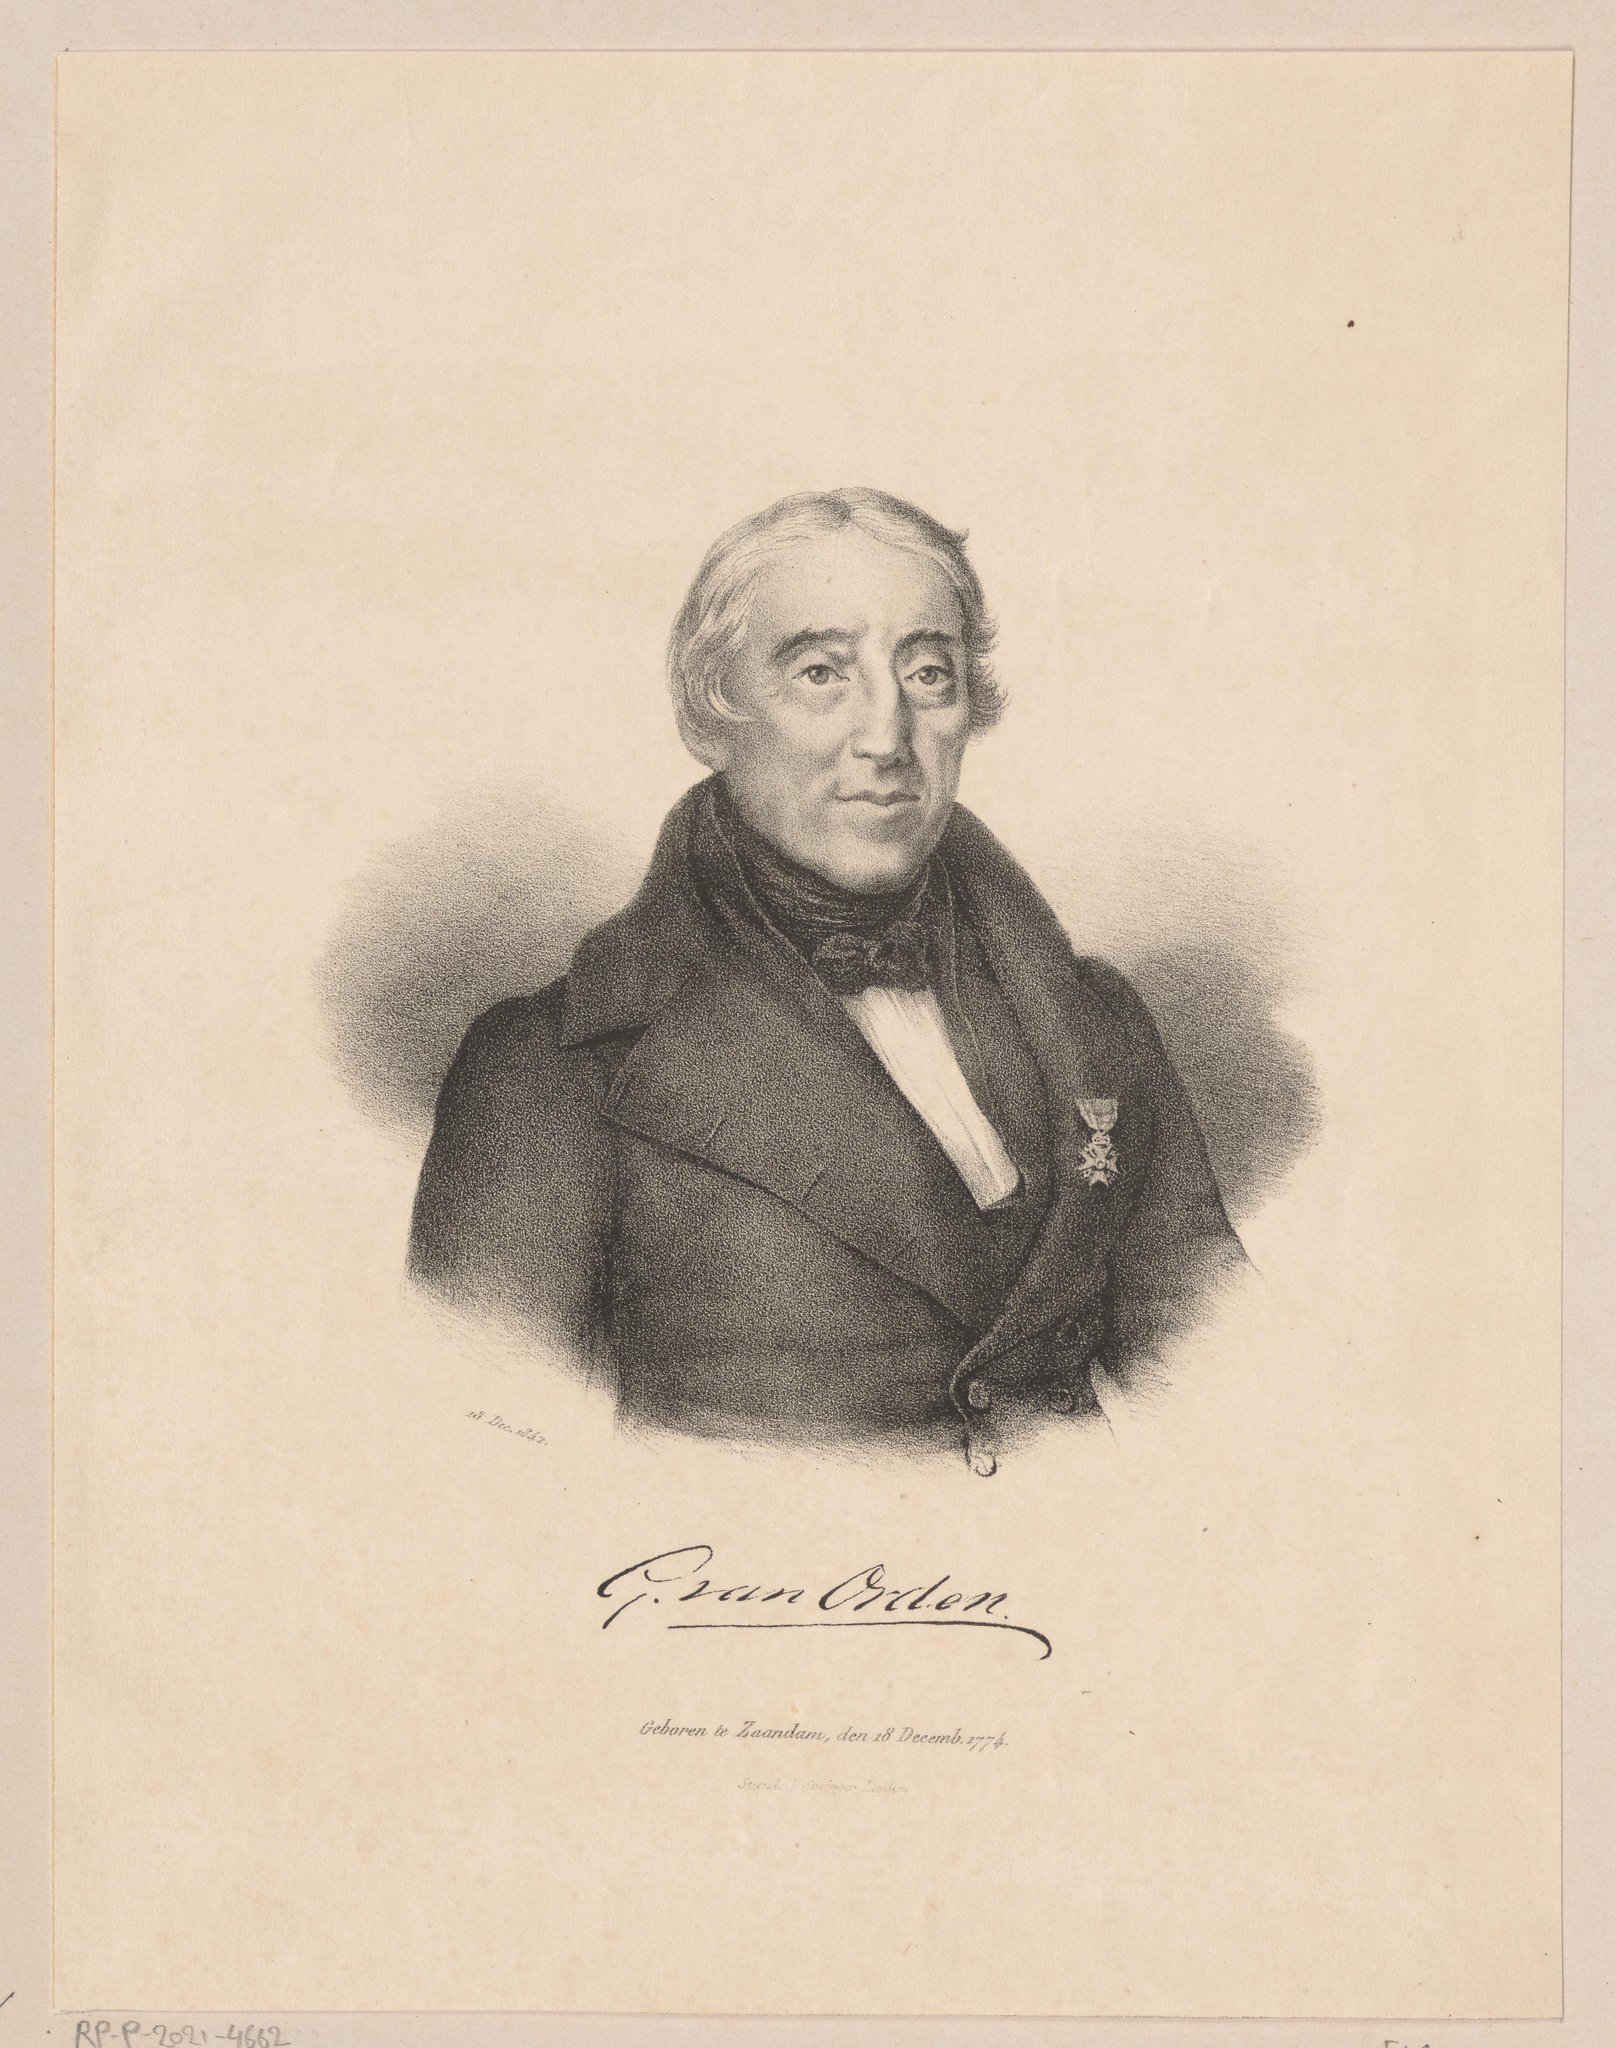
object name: print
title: Portret van Gerrit van Orden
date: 1842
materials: paper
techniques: lithograph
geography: leiden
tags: mayor, gerrit van orden, historical persons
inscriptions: date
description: Onder het portret een facsimile van de handtekening van de geportretteerde.